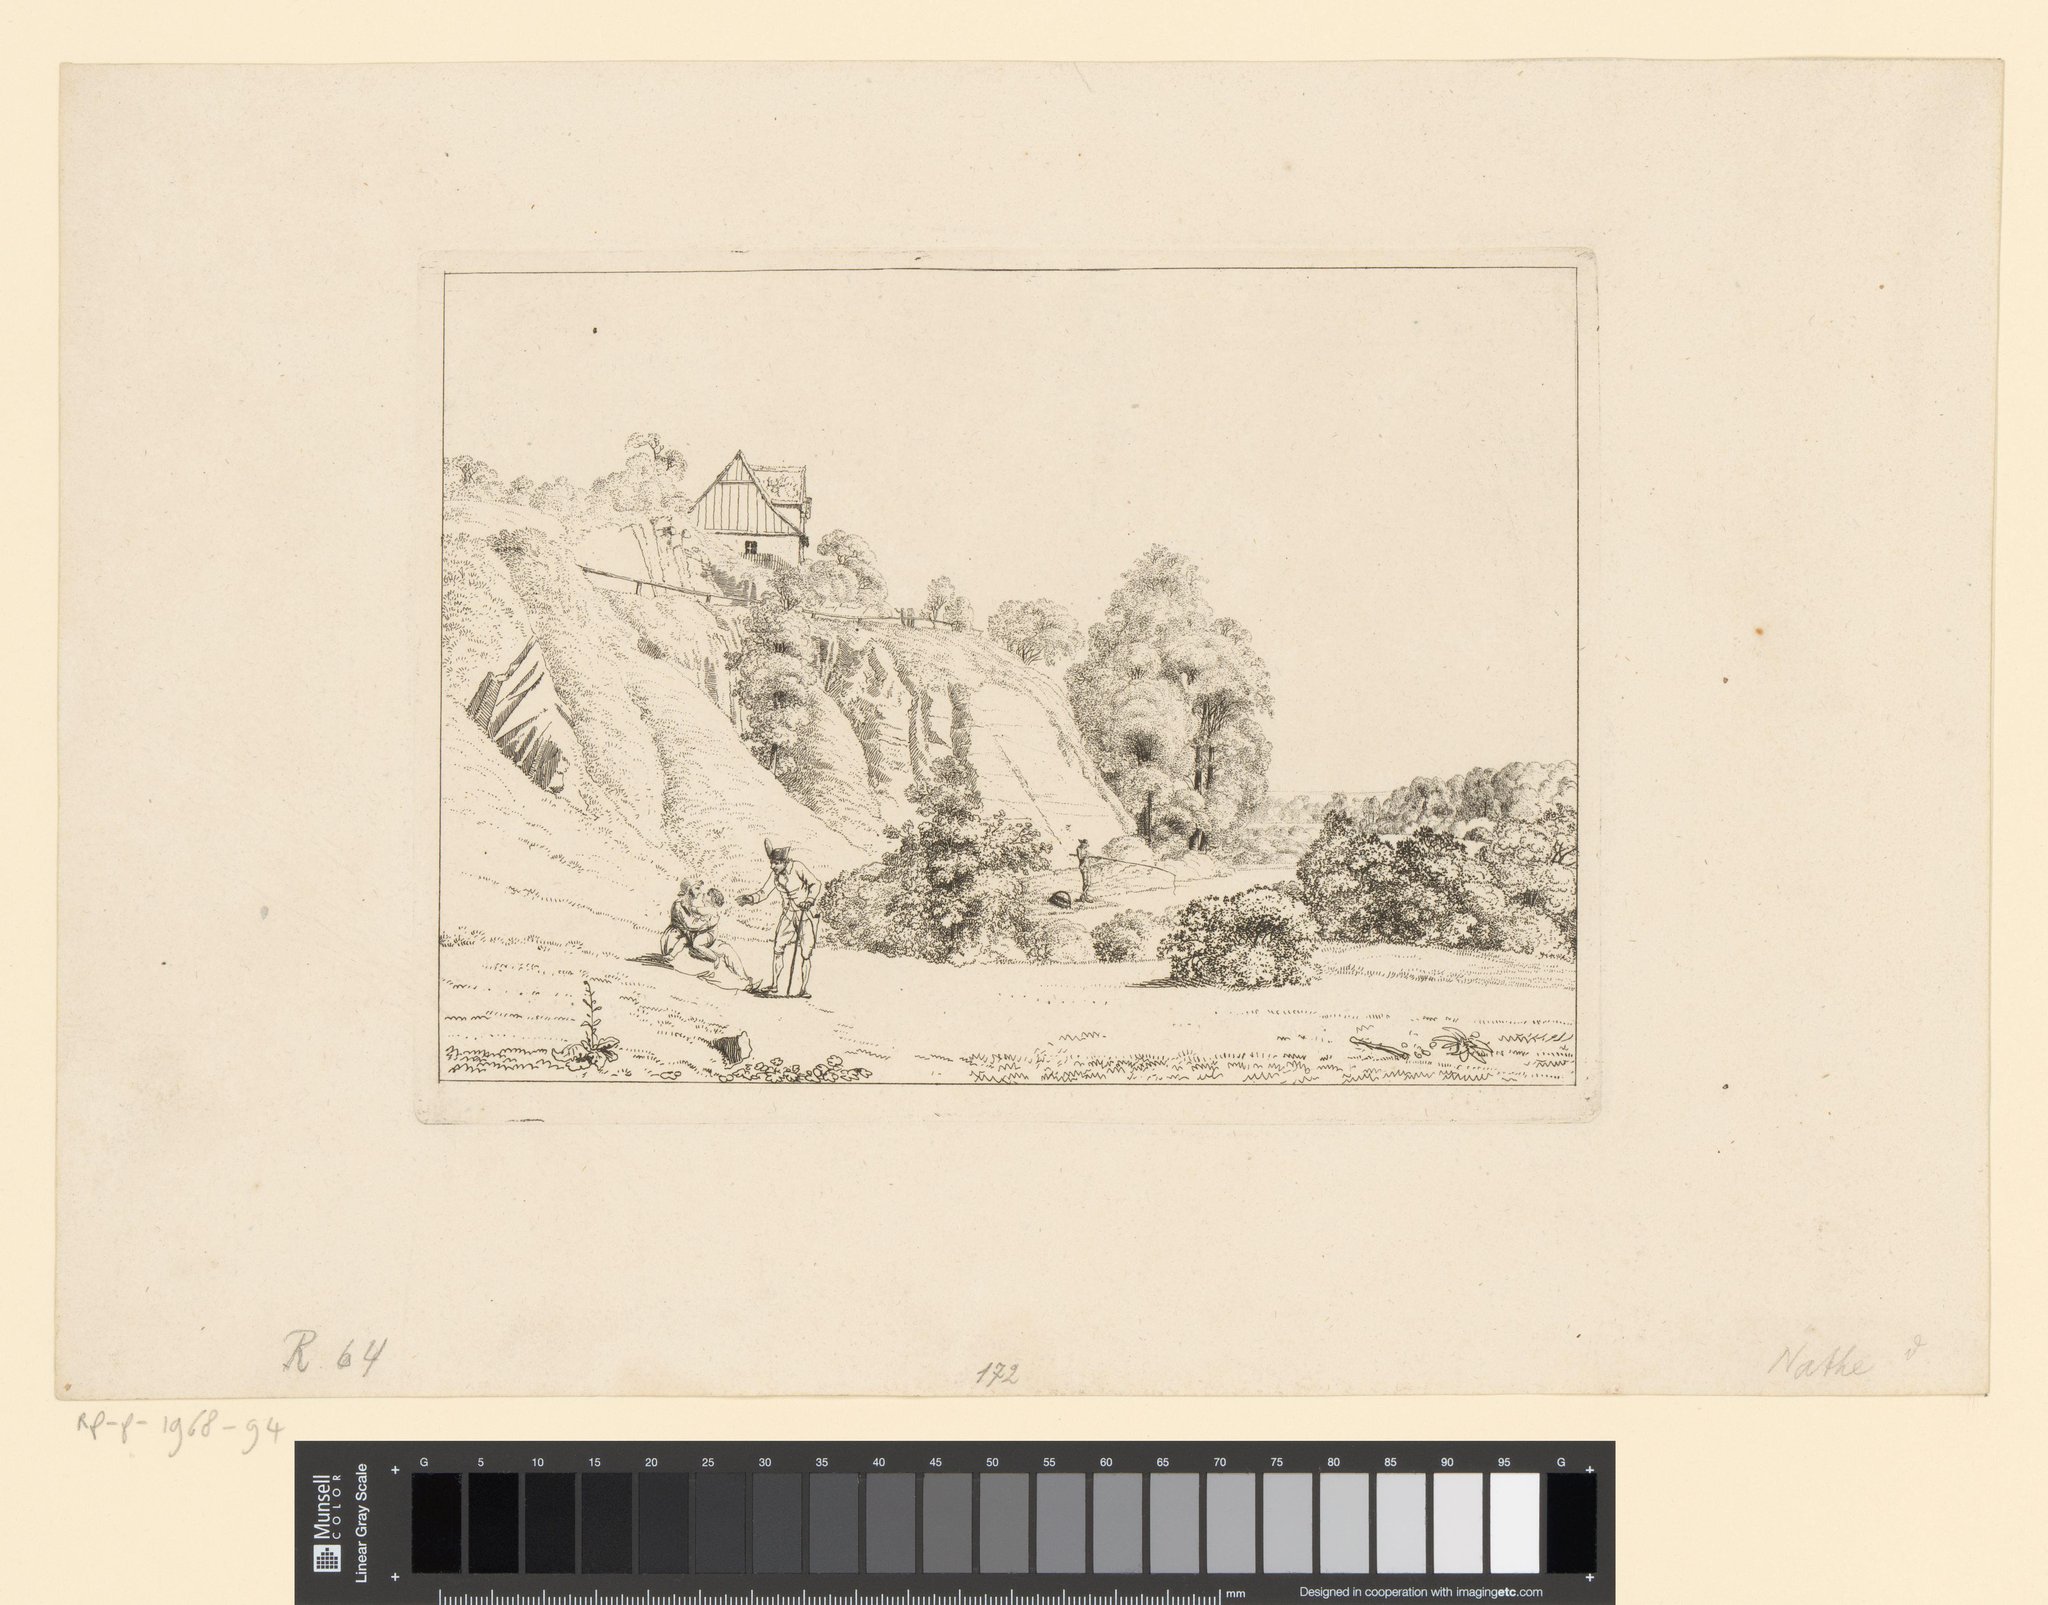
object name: print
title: Gezicht op het oude ziekenhuis van Görlitz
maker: christoph nathe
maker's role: print maker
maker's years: 1753-1806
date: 1763-1806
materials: paper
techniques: etching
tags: landscapes, family life, hospital, fisherman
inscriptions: collector's mark: Lugt 2760, collector's mark: Lugt 2228